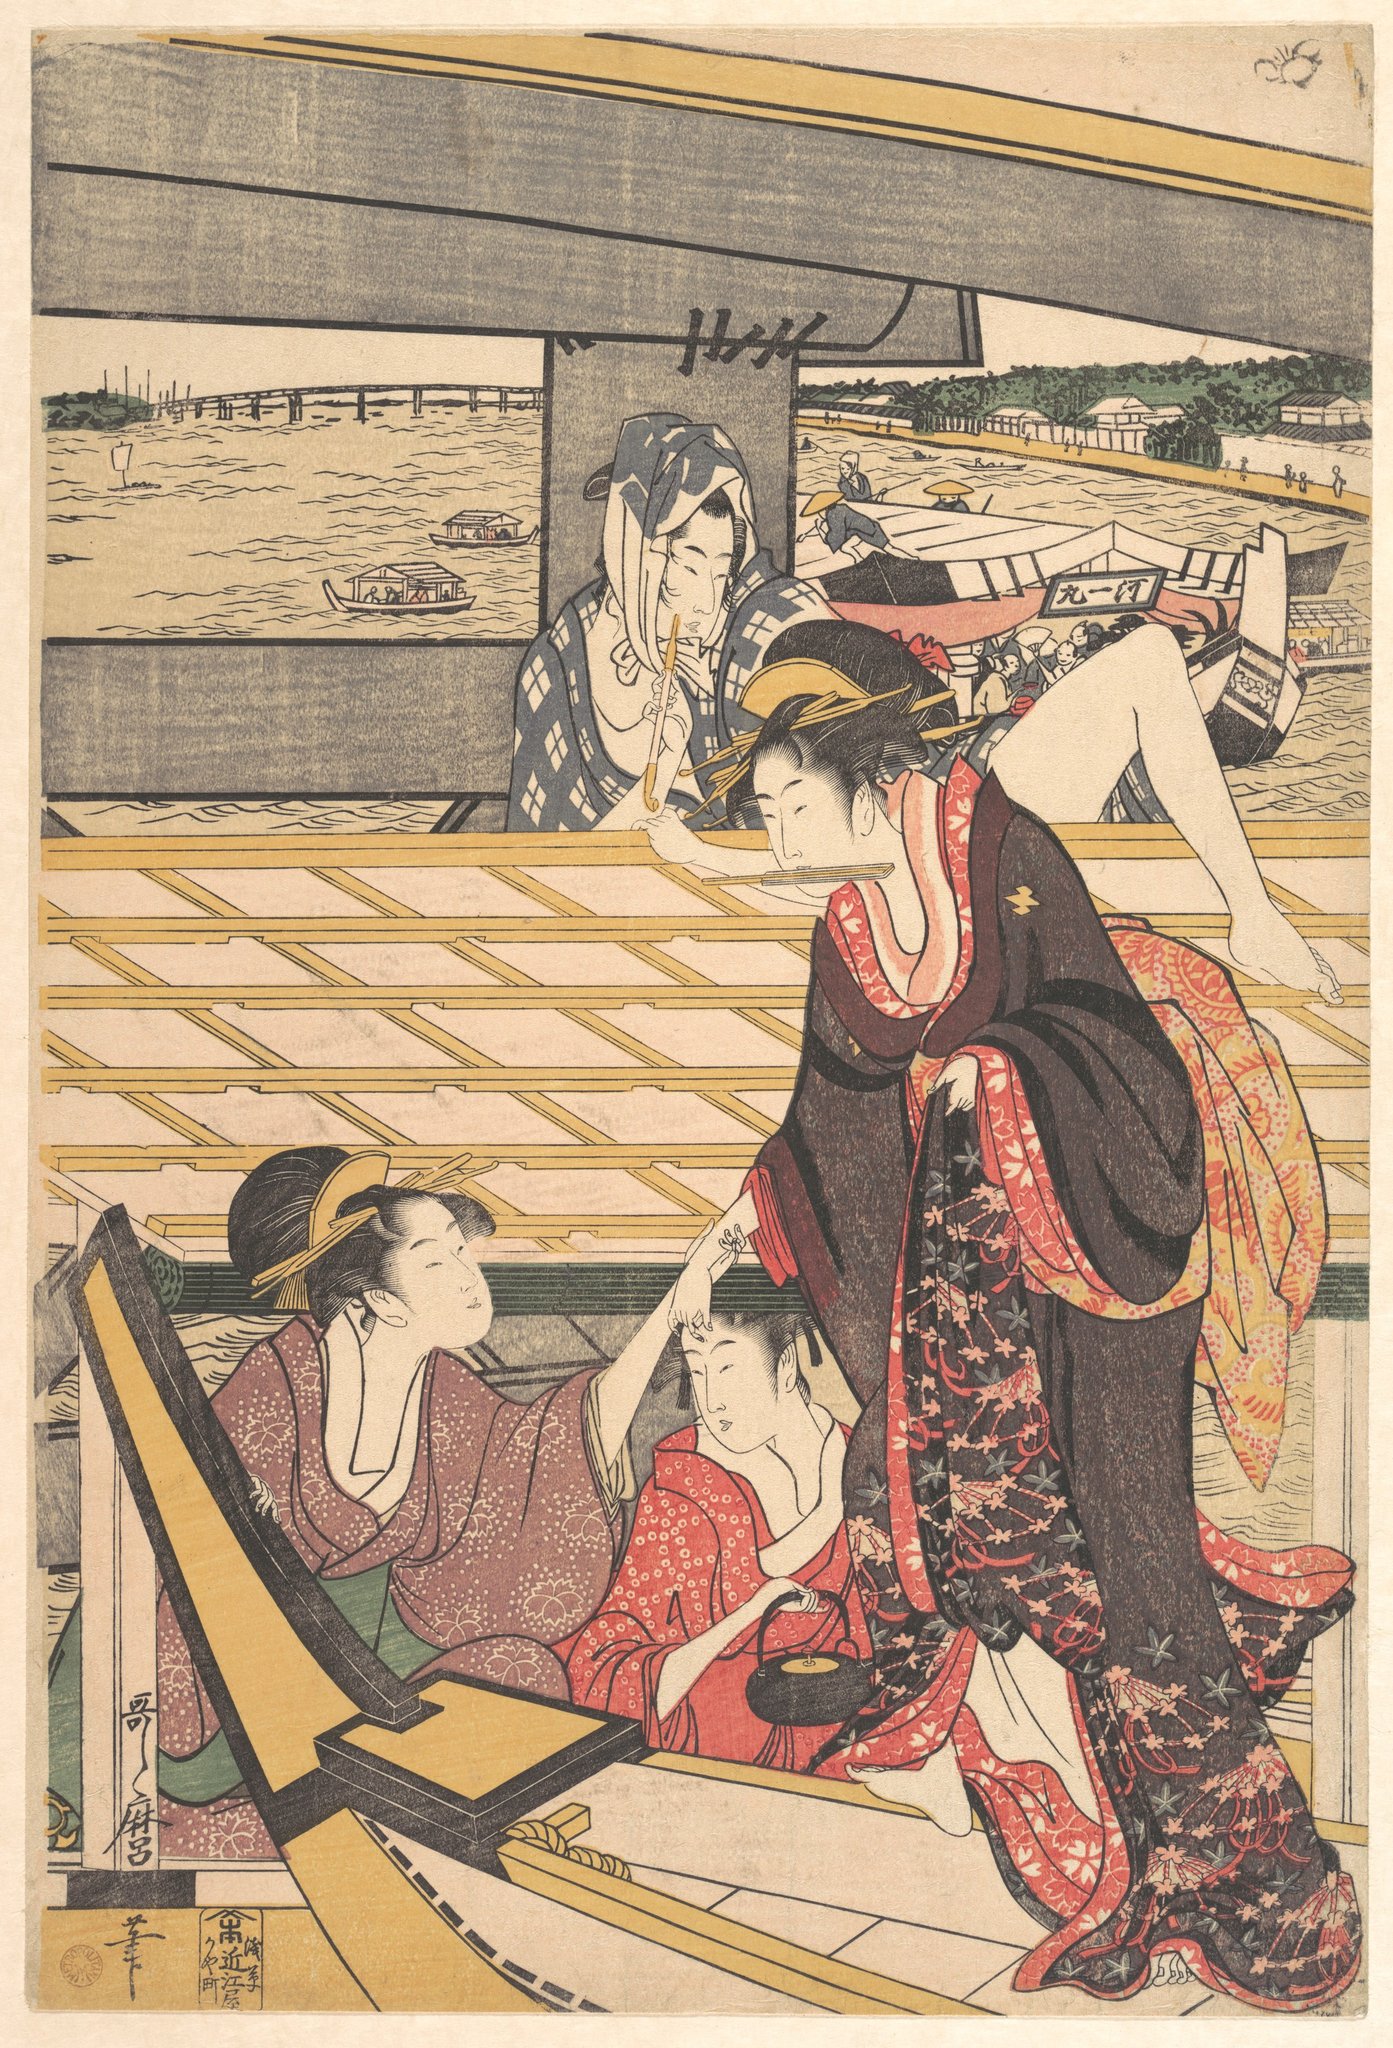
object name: print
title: Pleasure Parties in Boats on the Sumida River under the Ryogoku Bridge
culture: japanese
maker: kitagawa utamaro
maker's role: artist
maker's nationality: japanese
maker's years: 1754-1806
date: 1796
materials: ink, paper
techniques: woodblock print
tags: bridges,women,rivers,boats